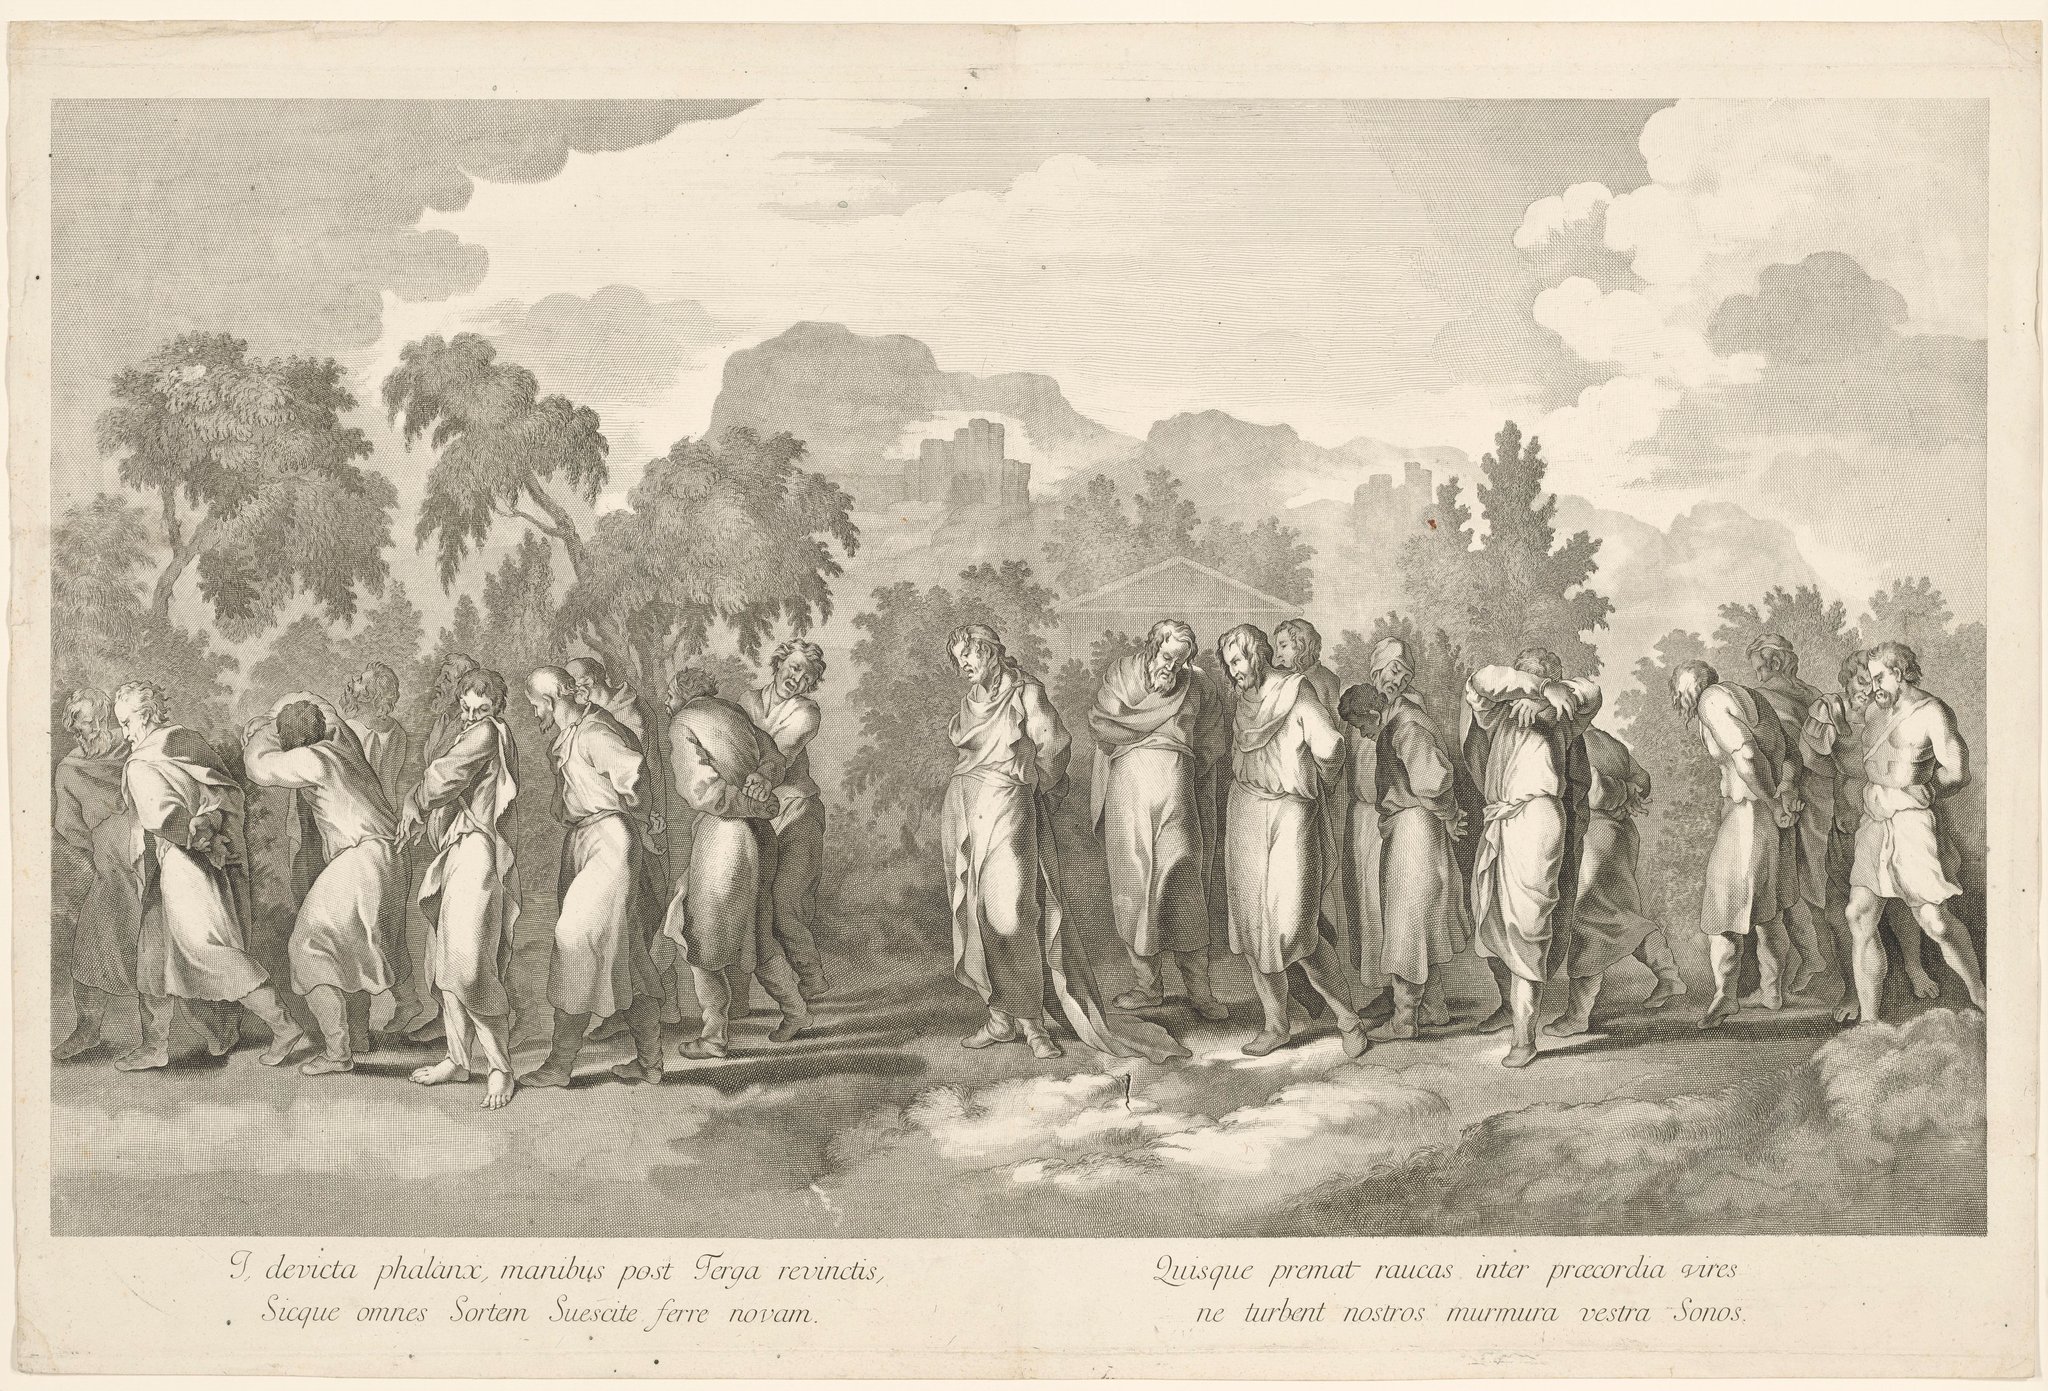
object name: print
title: Stoet gevangenen in landschap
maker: domenico rossetti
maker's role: print maker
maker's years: 1650-1736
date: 1660-1736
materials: paper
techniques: engraving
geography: italy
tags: prisoner of war (after the battle)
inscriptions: collector's mark: Lugt 2228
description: Deze prent maakt deel uit van een reeks van twaalf prenten door verschillende prentmakers naar de grisailles door Gerard de Lairesse in Schloss Mannheim van de Triomftocht van Alexander de Grote in Babylon.